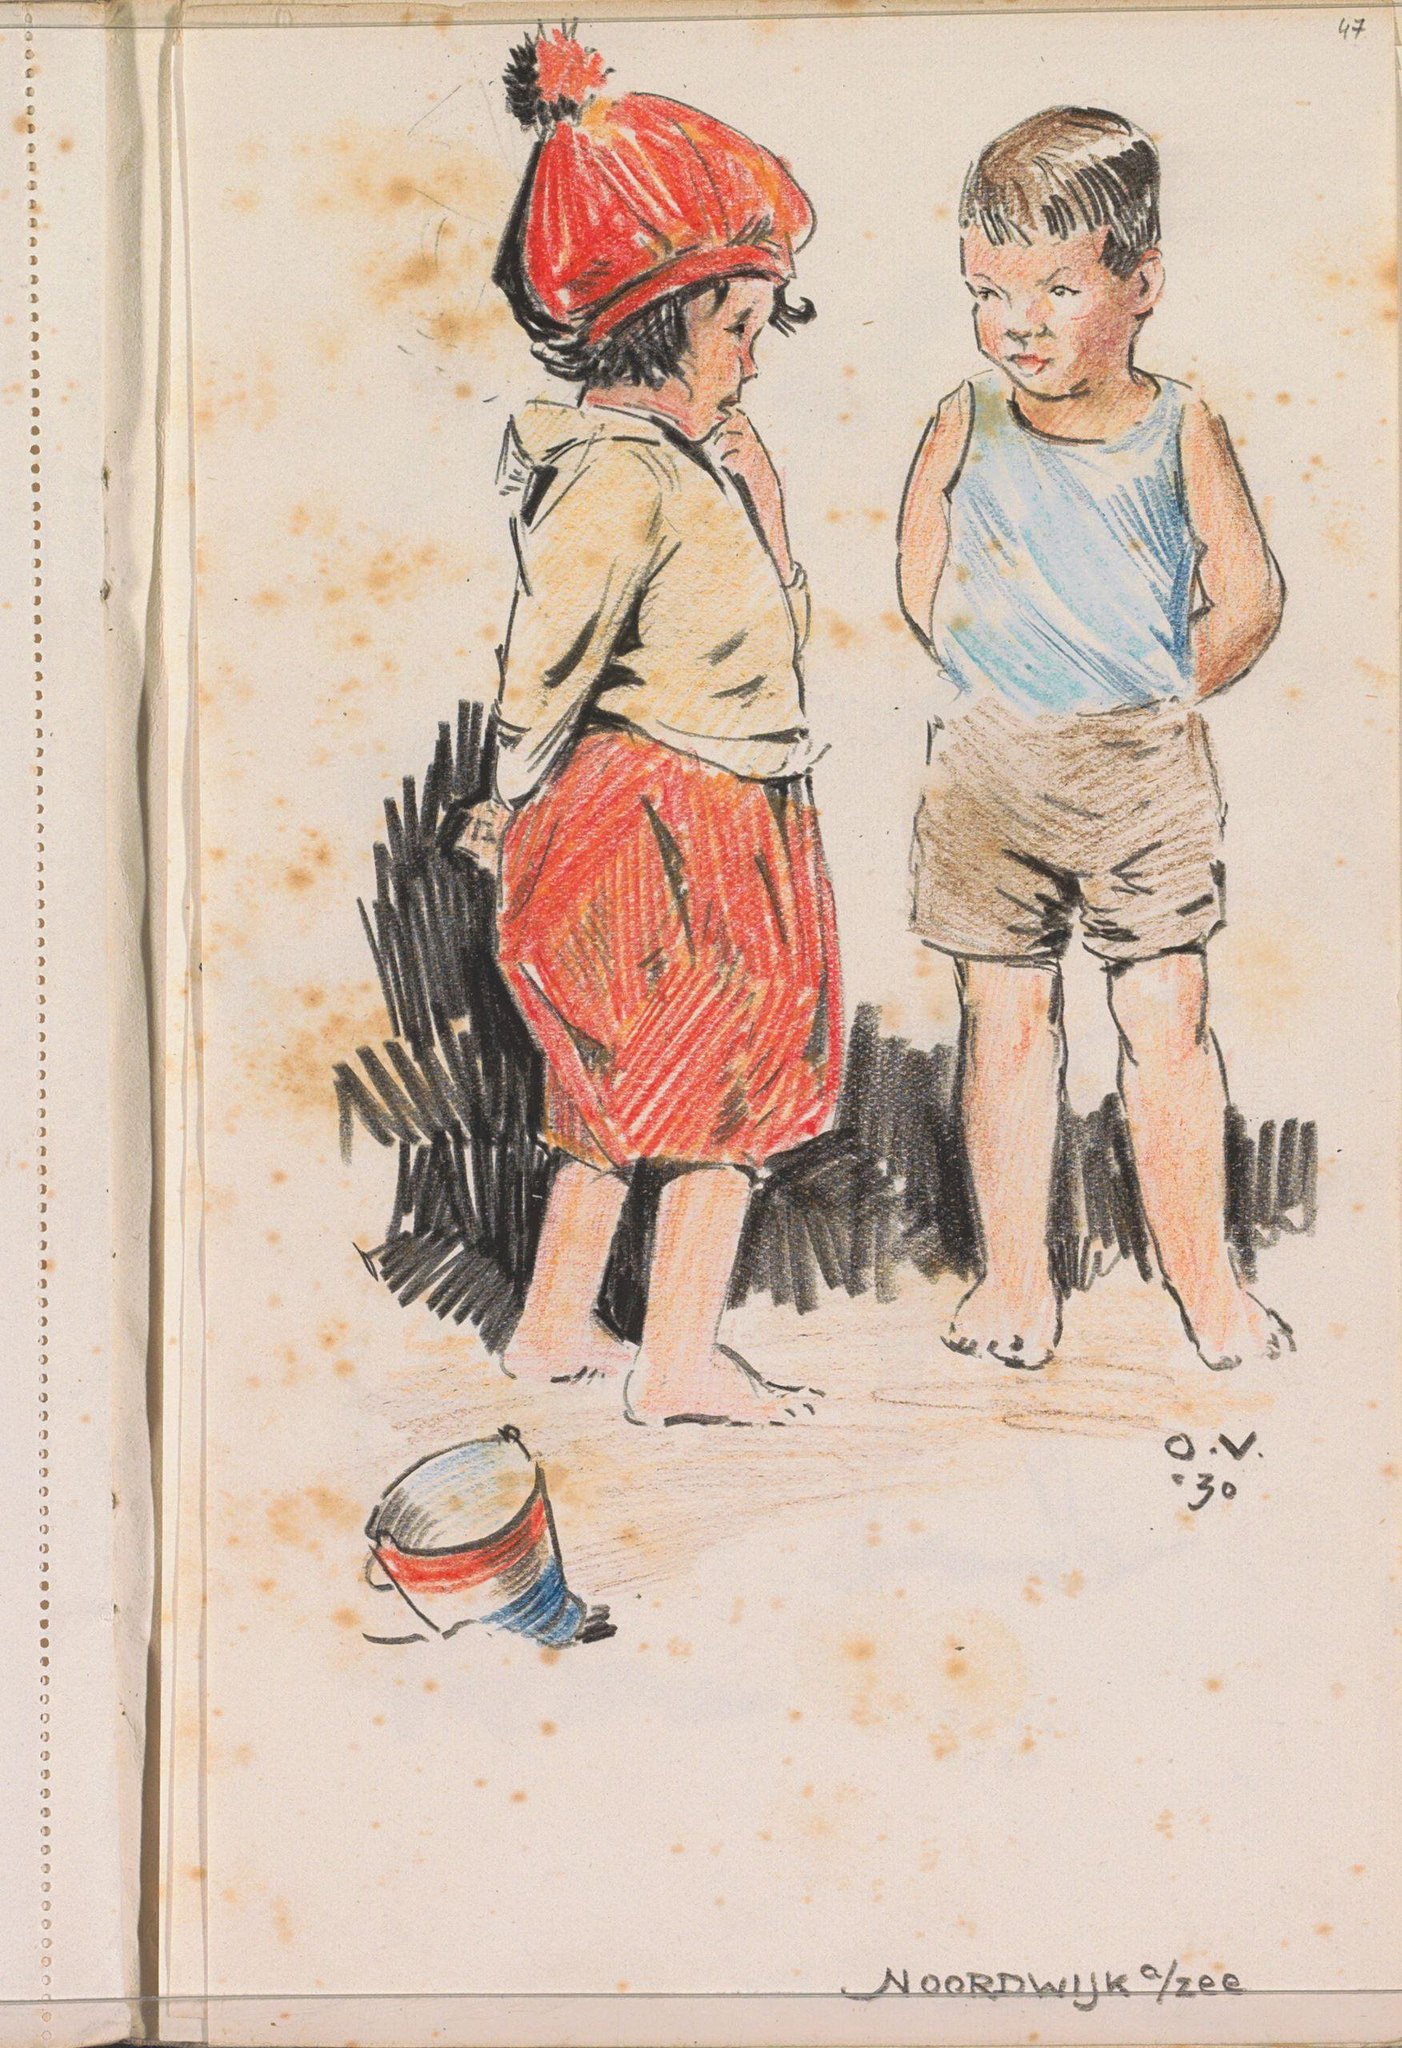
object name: sketchbook leaf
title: Jongen en meisje op het strand van Noordwijk aan Zee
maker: otto verhagen (i)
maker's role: draughtsman, print maker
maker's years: 1885-1951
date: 1930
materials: chalk, paper, pencil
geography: noordwijk aan zee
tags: child, beach (+ landscape with figures, staffage)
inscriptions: annotation: ‘NOORDWIJK a/Zee’, signature and date: ‘O.V./ '30’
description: Voor de kinderen ligt een emmer in het zand. Pagina 47 uit een schetsboek met 51 bladen.